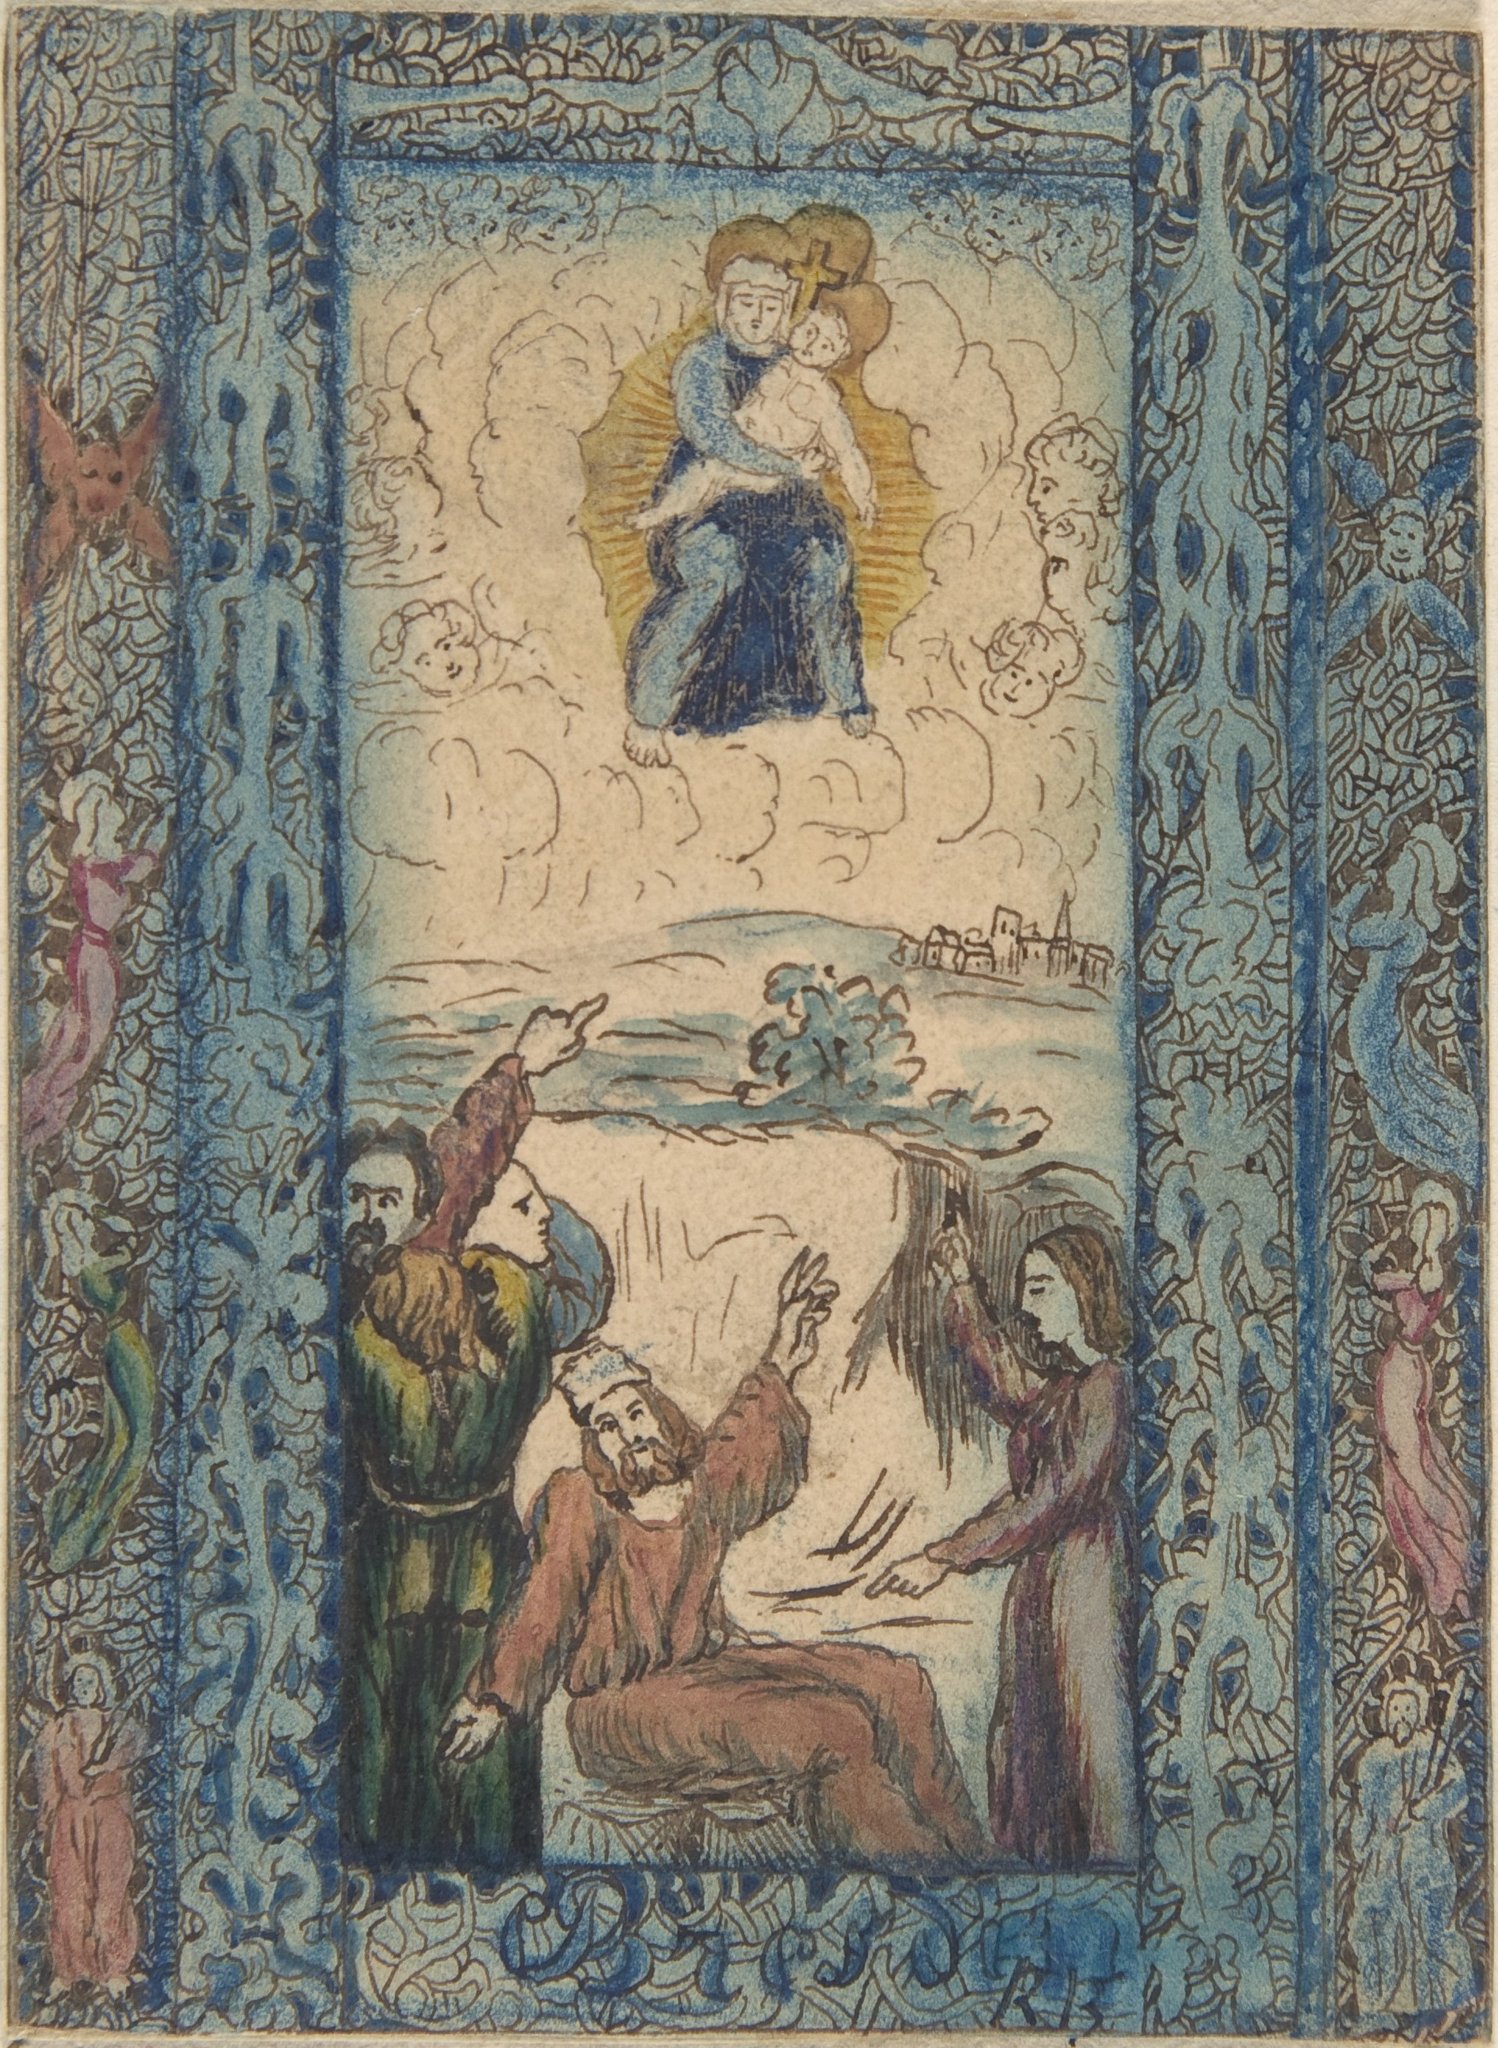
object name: drawing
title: Design for a Stained Glass Window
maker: rodolphe bresdin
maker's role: artist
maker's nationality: french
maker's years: 1822-1885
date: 1822-1885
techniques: brush, wash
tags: men,women,madonna and child,cross